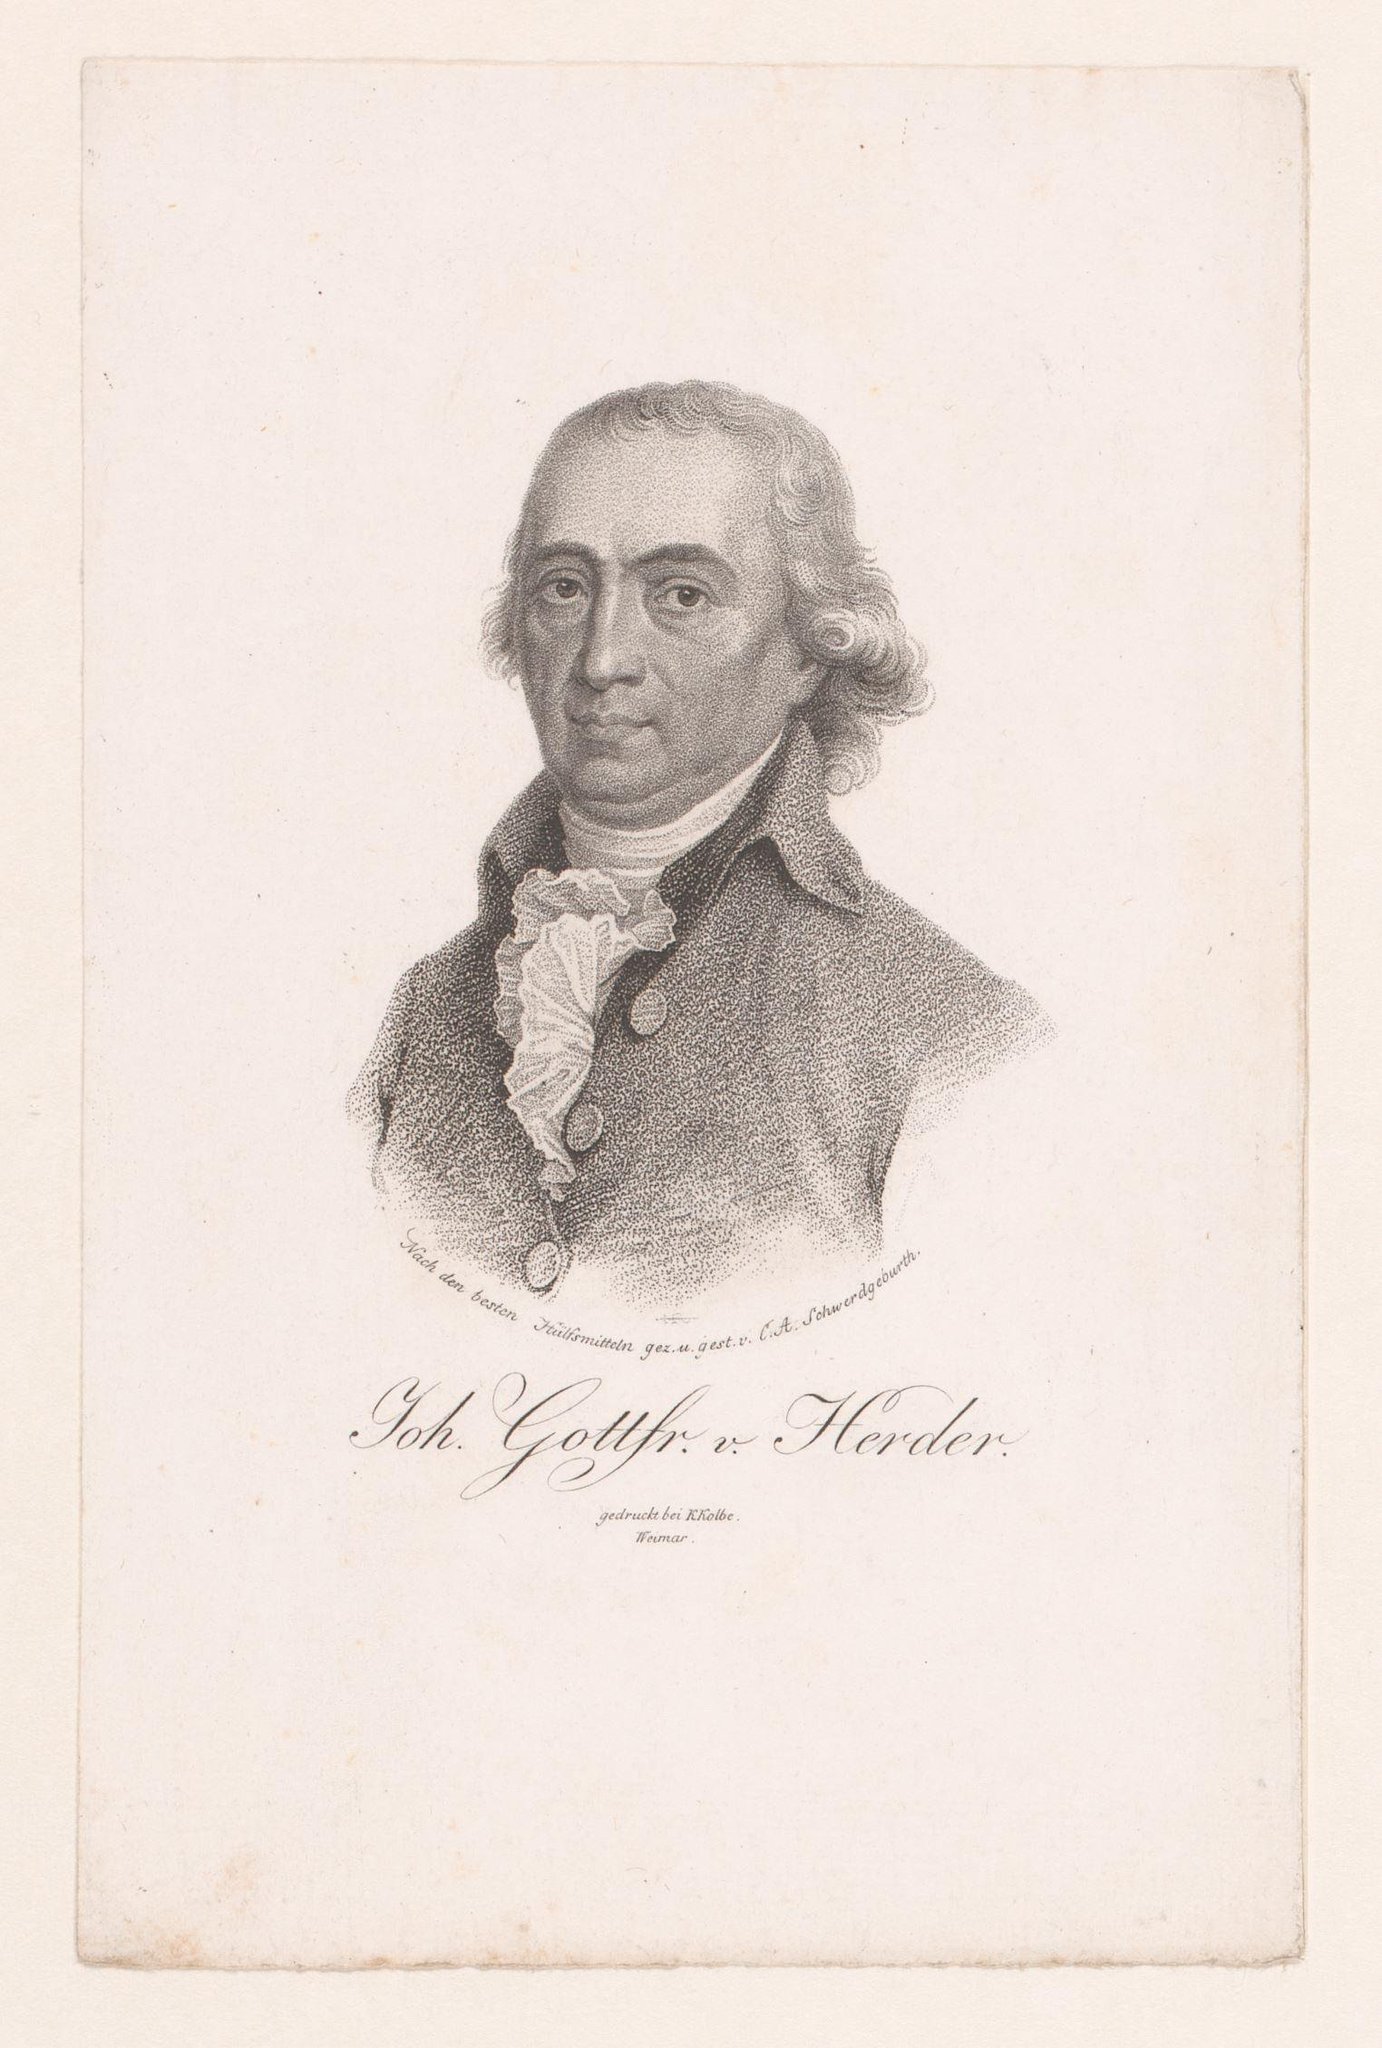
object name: print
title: Portret van Johann Gottfried von Herder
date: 1795-1878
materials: paper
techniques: engraving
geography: weimar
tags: historical persons, writer, poet, author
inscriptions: collector's mark: Lugt 2228